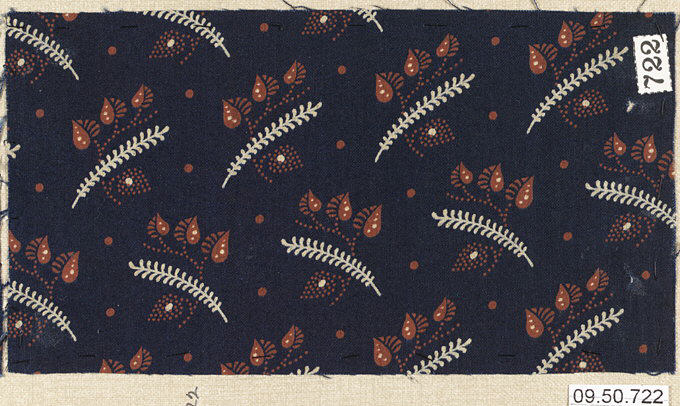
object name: piece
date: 1801-1900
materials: cotton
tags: leaves